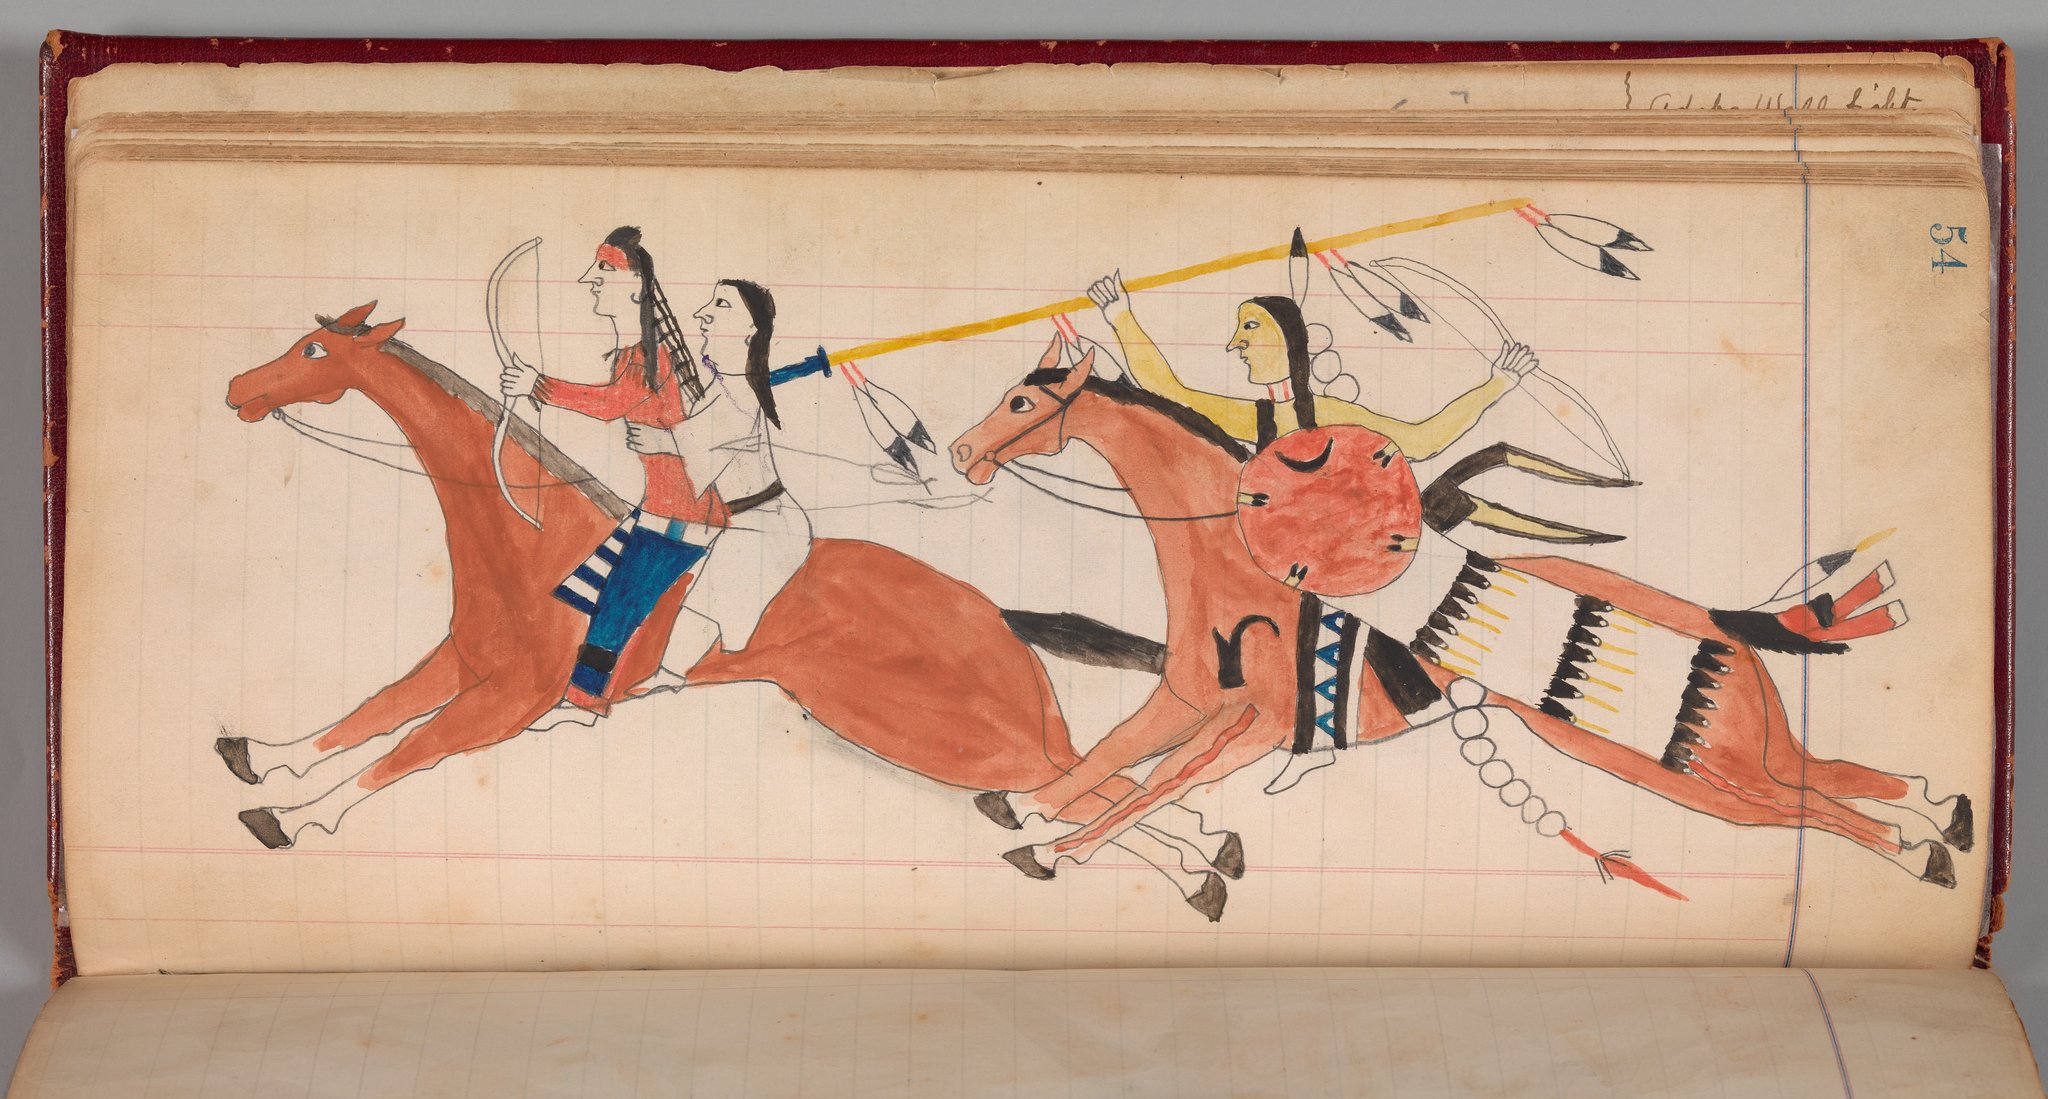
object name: drawing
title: Maffet Ledger: Drawing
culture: cheyenne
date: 1874-1881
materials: crayon, graphite, paper, watercolor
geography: united states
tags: men,horses